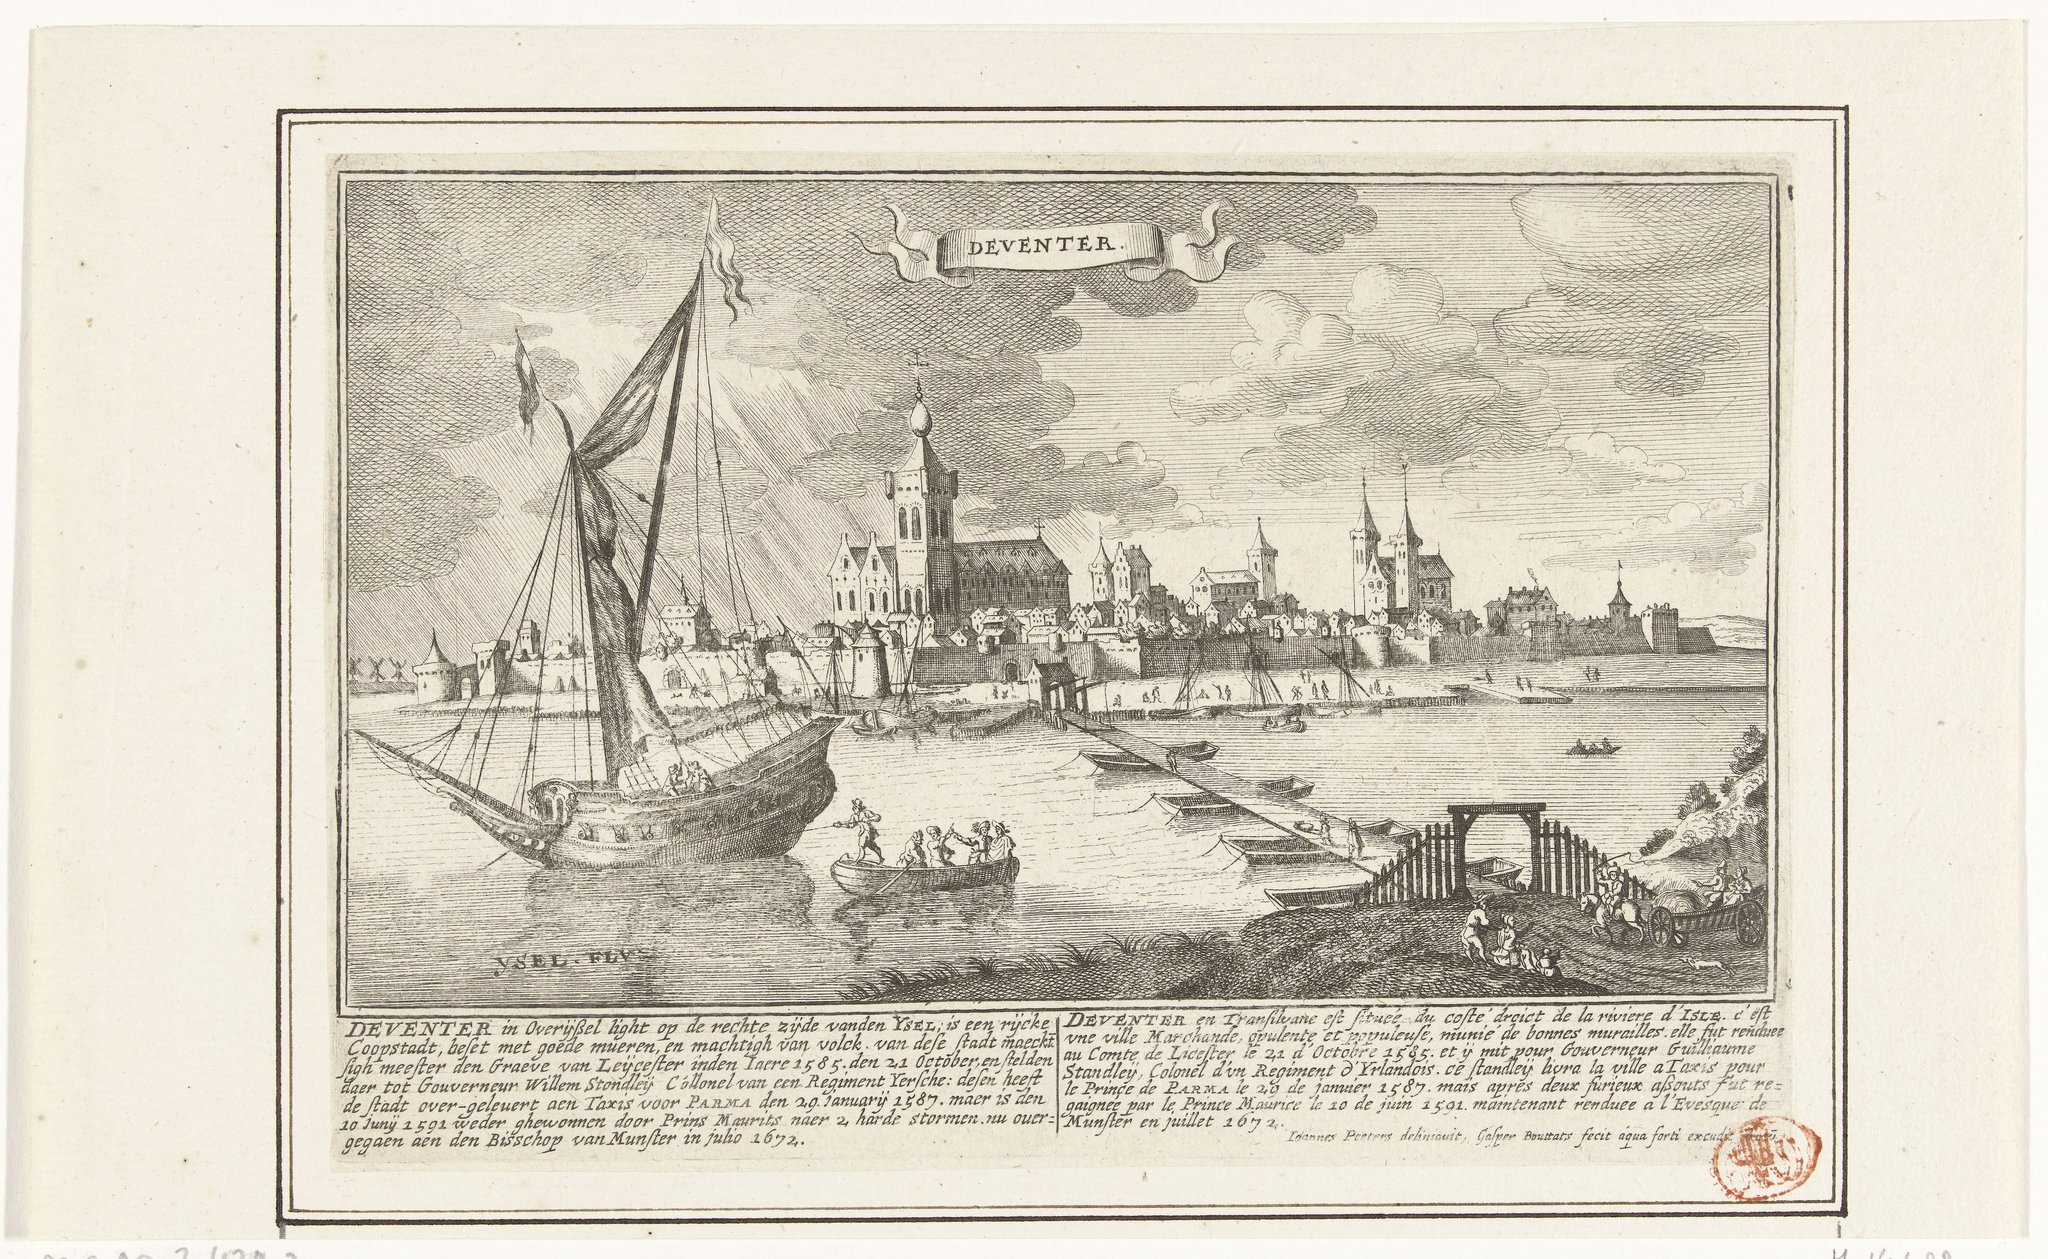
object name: print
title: Thooneel der Steden ende Sterckten van 't Vereenight Nederlandt met d'aengrensende Plaetsen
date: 1679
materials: paper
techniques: etching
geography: antwerp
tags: prospect of city, town panorama, silhouette of city, deventer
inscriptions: collector's mark: Lugt 195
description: Gezicht op de stad Deventer. Op de voorgrond, buiten de stadsmuren, de rivier De Ijsel. Een sloep brengt passagiers naar een zeilschip. Wandelaars en karren gaan over de brug richting Deventer. Boven het stadsgezicht een cartouche met de naam van de stad. De prent heeft een Nederlands en Frans onderschrift.